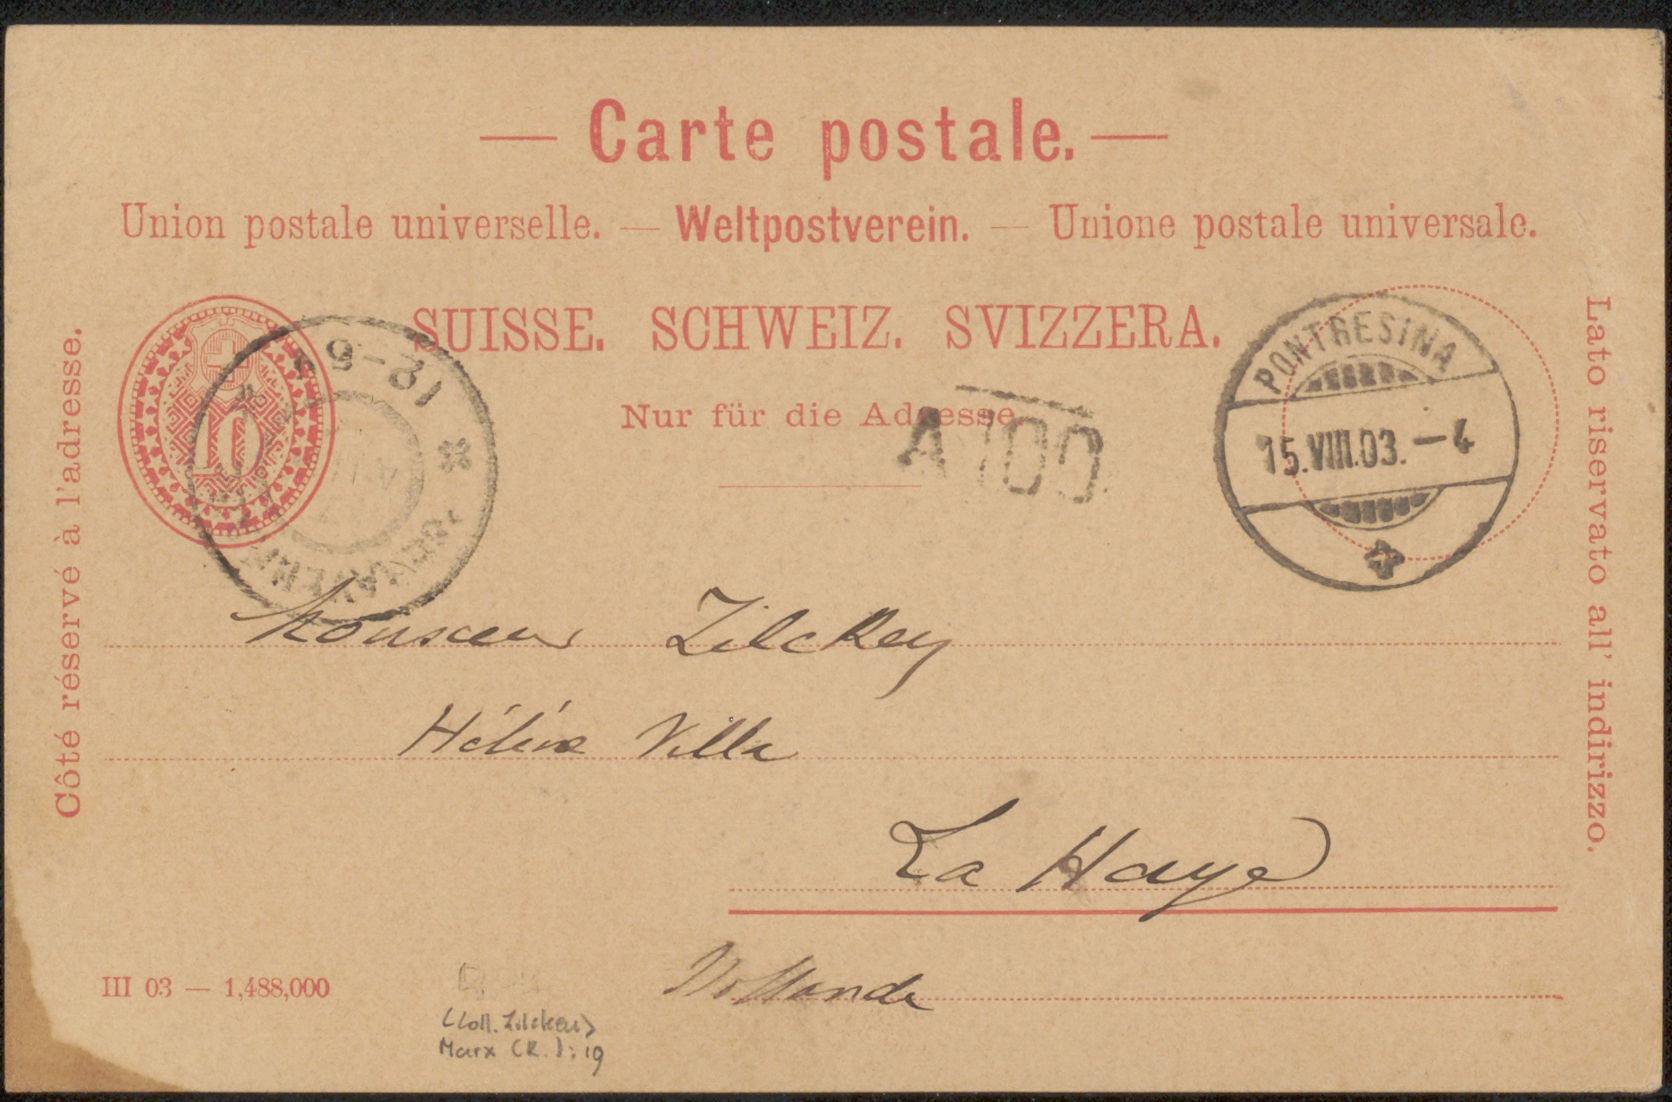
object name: postcard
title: Briefkaart aan Philip Zilcken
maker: roger marx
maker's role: kunstcriticus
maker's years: 1859-1913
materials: cardboard, ink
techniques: pen, writing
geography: switzerland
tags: amsterdam, print maker, draughtsman, pieter dupont, the hague, painter, philip zilcken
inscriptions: collector's mark: ‘RPK’